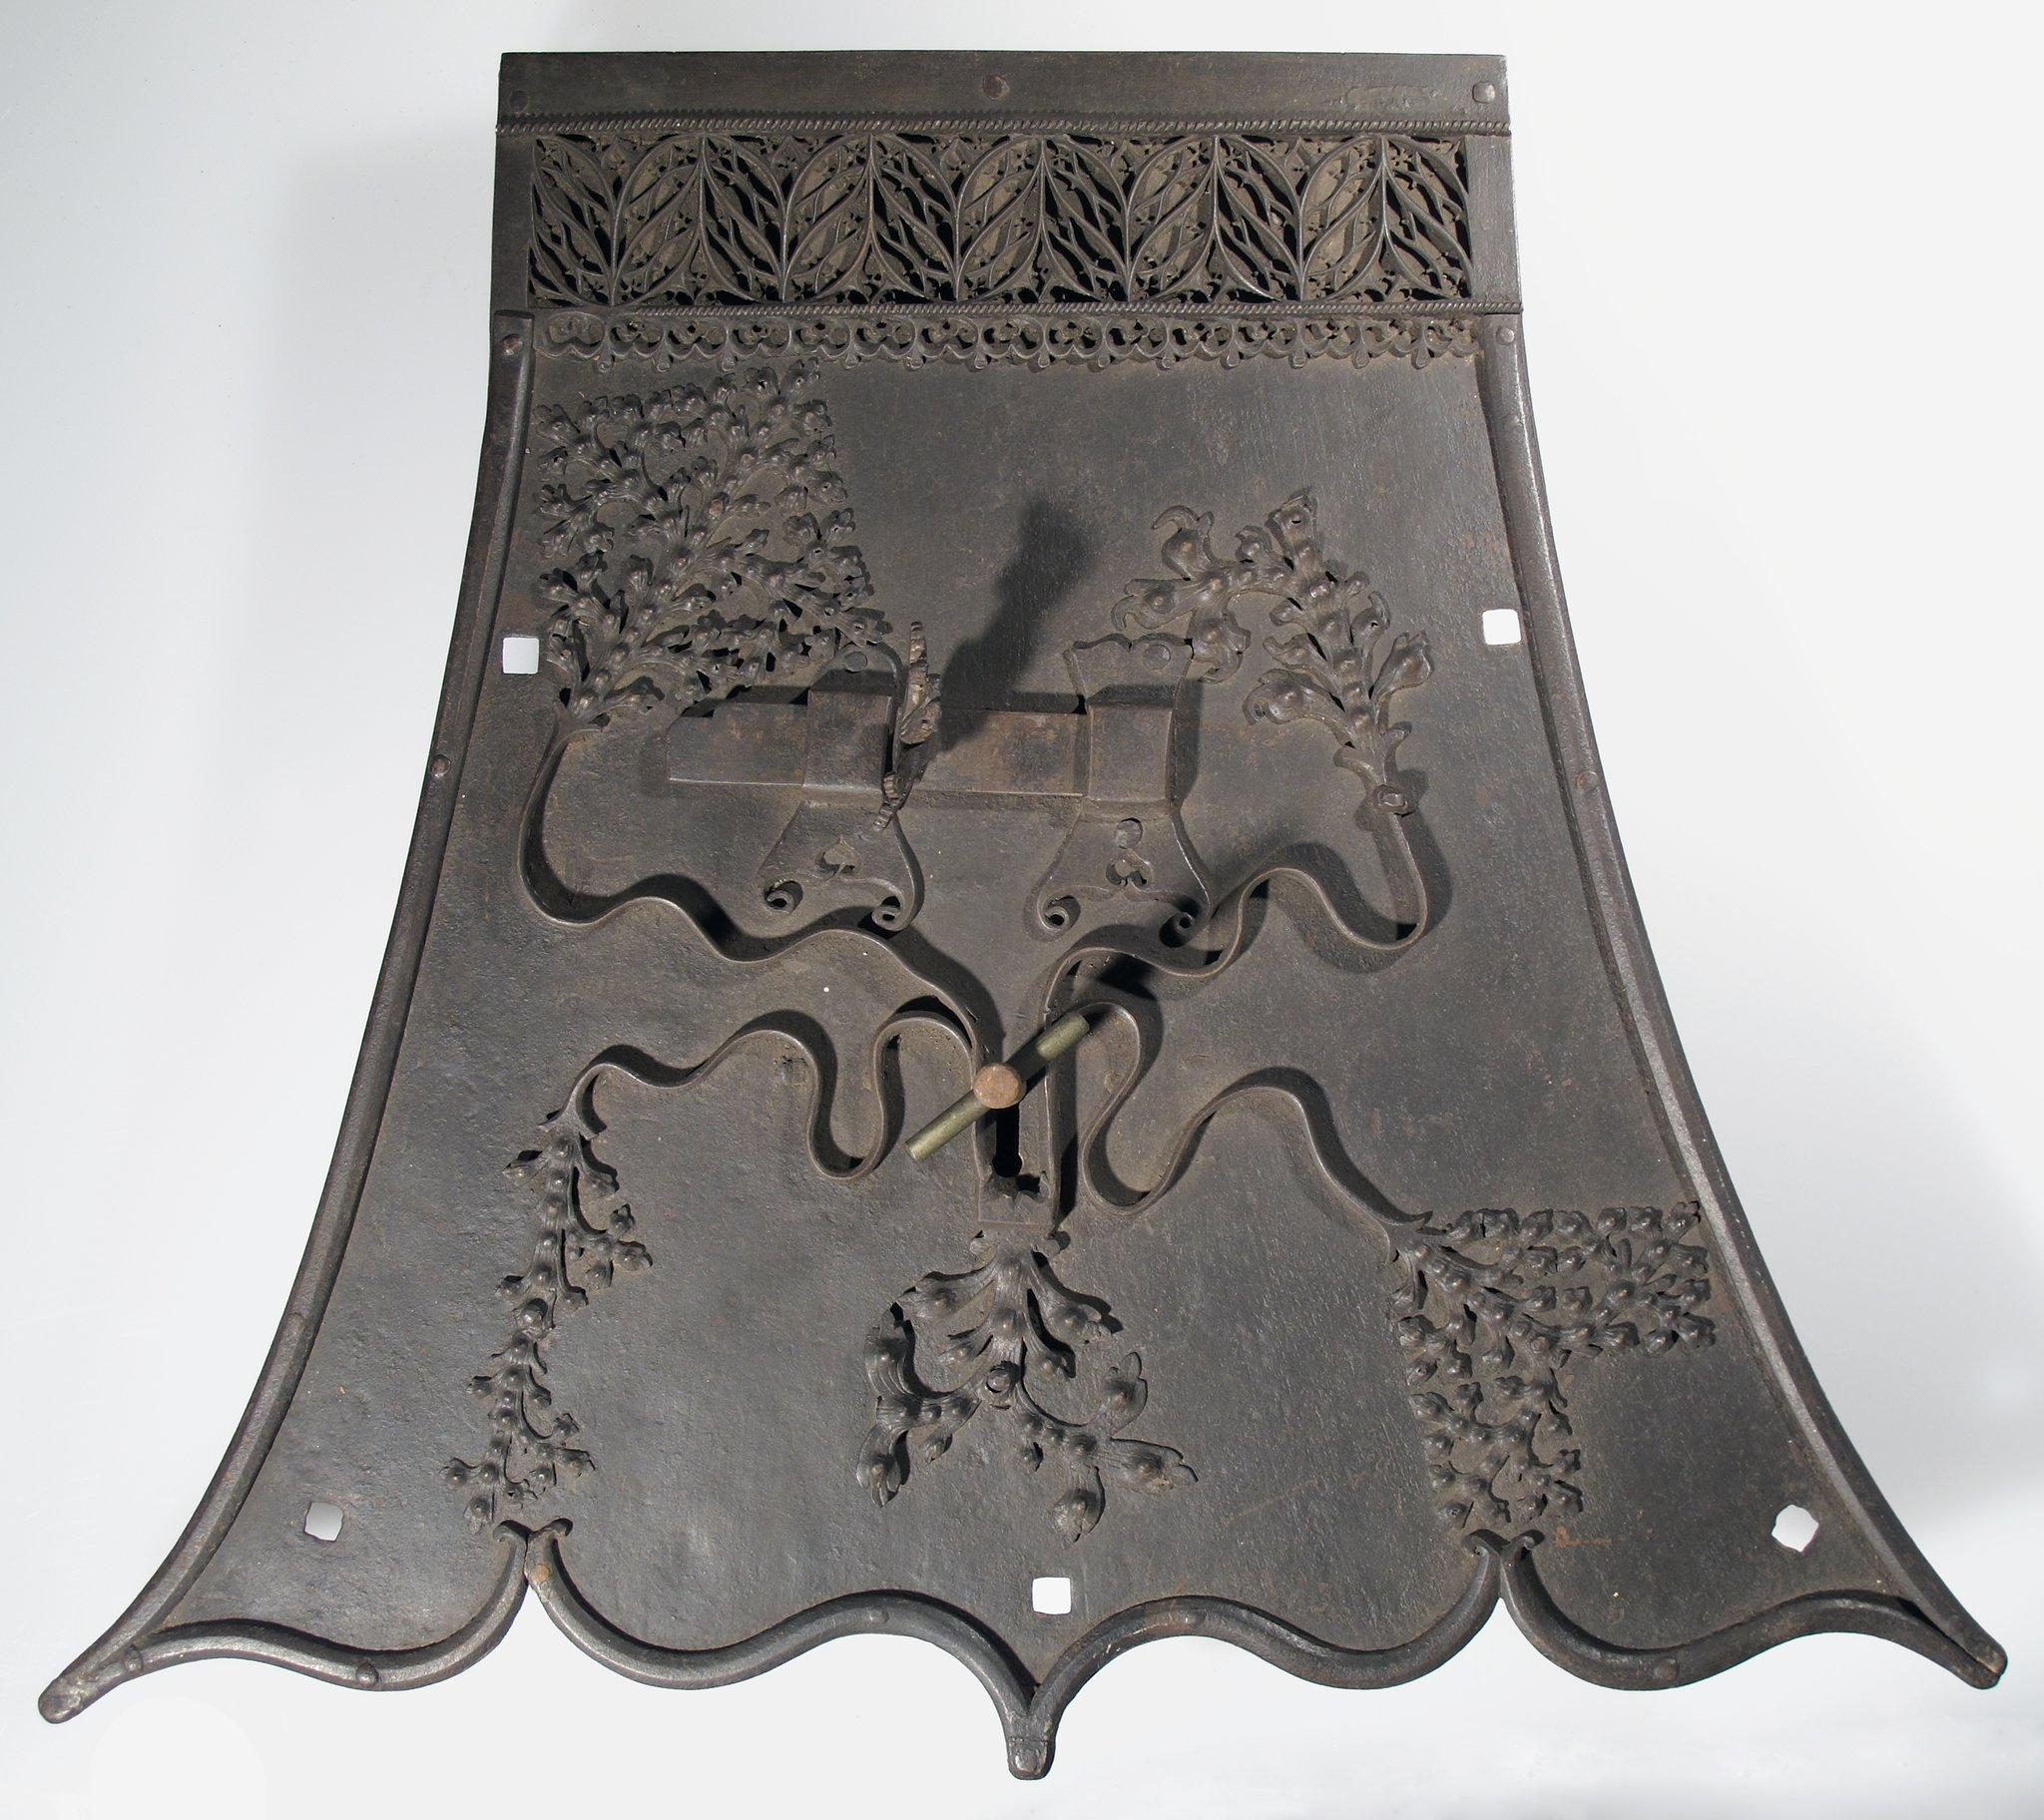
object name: lock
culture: european or german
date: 1401-1600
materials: iron